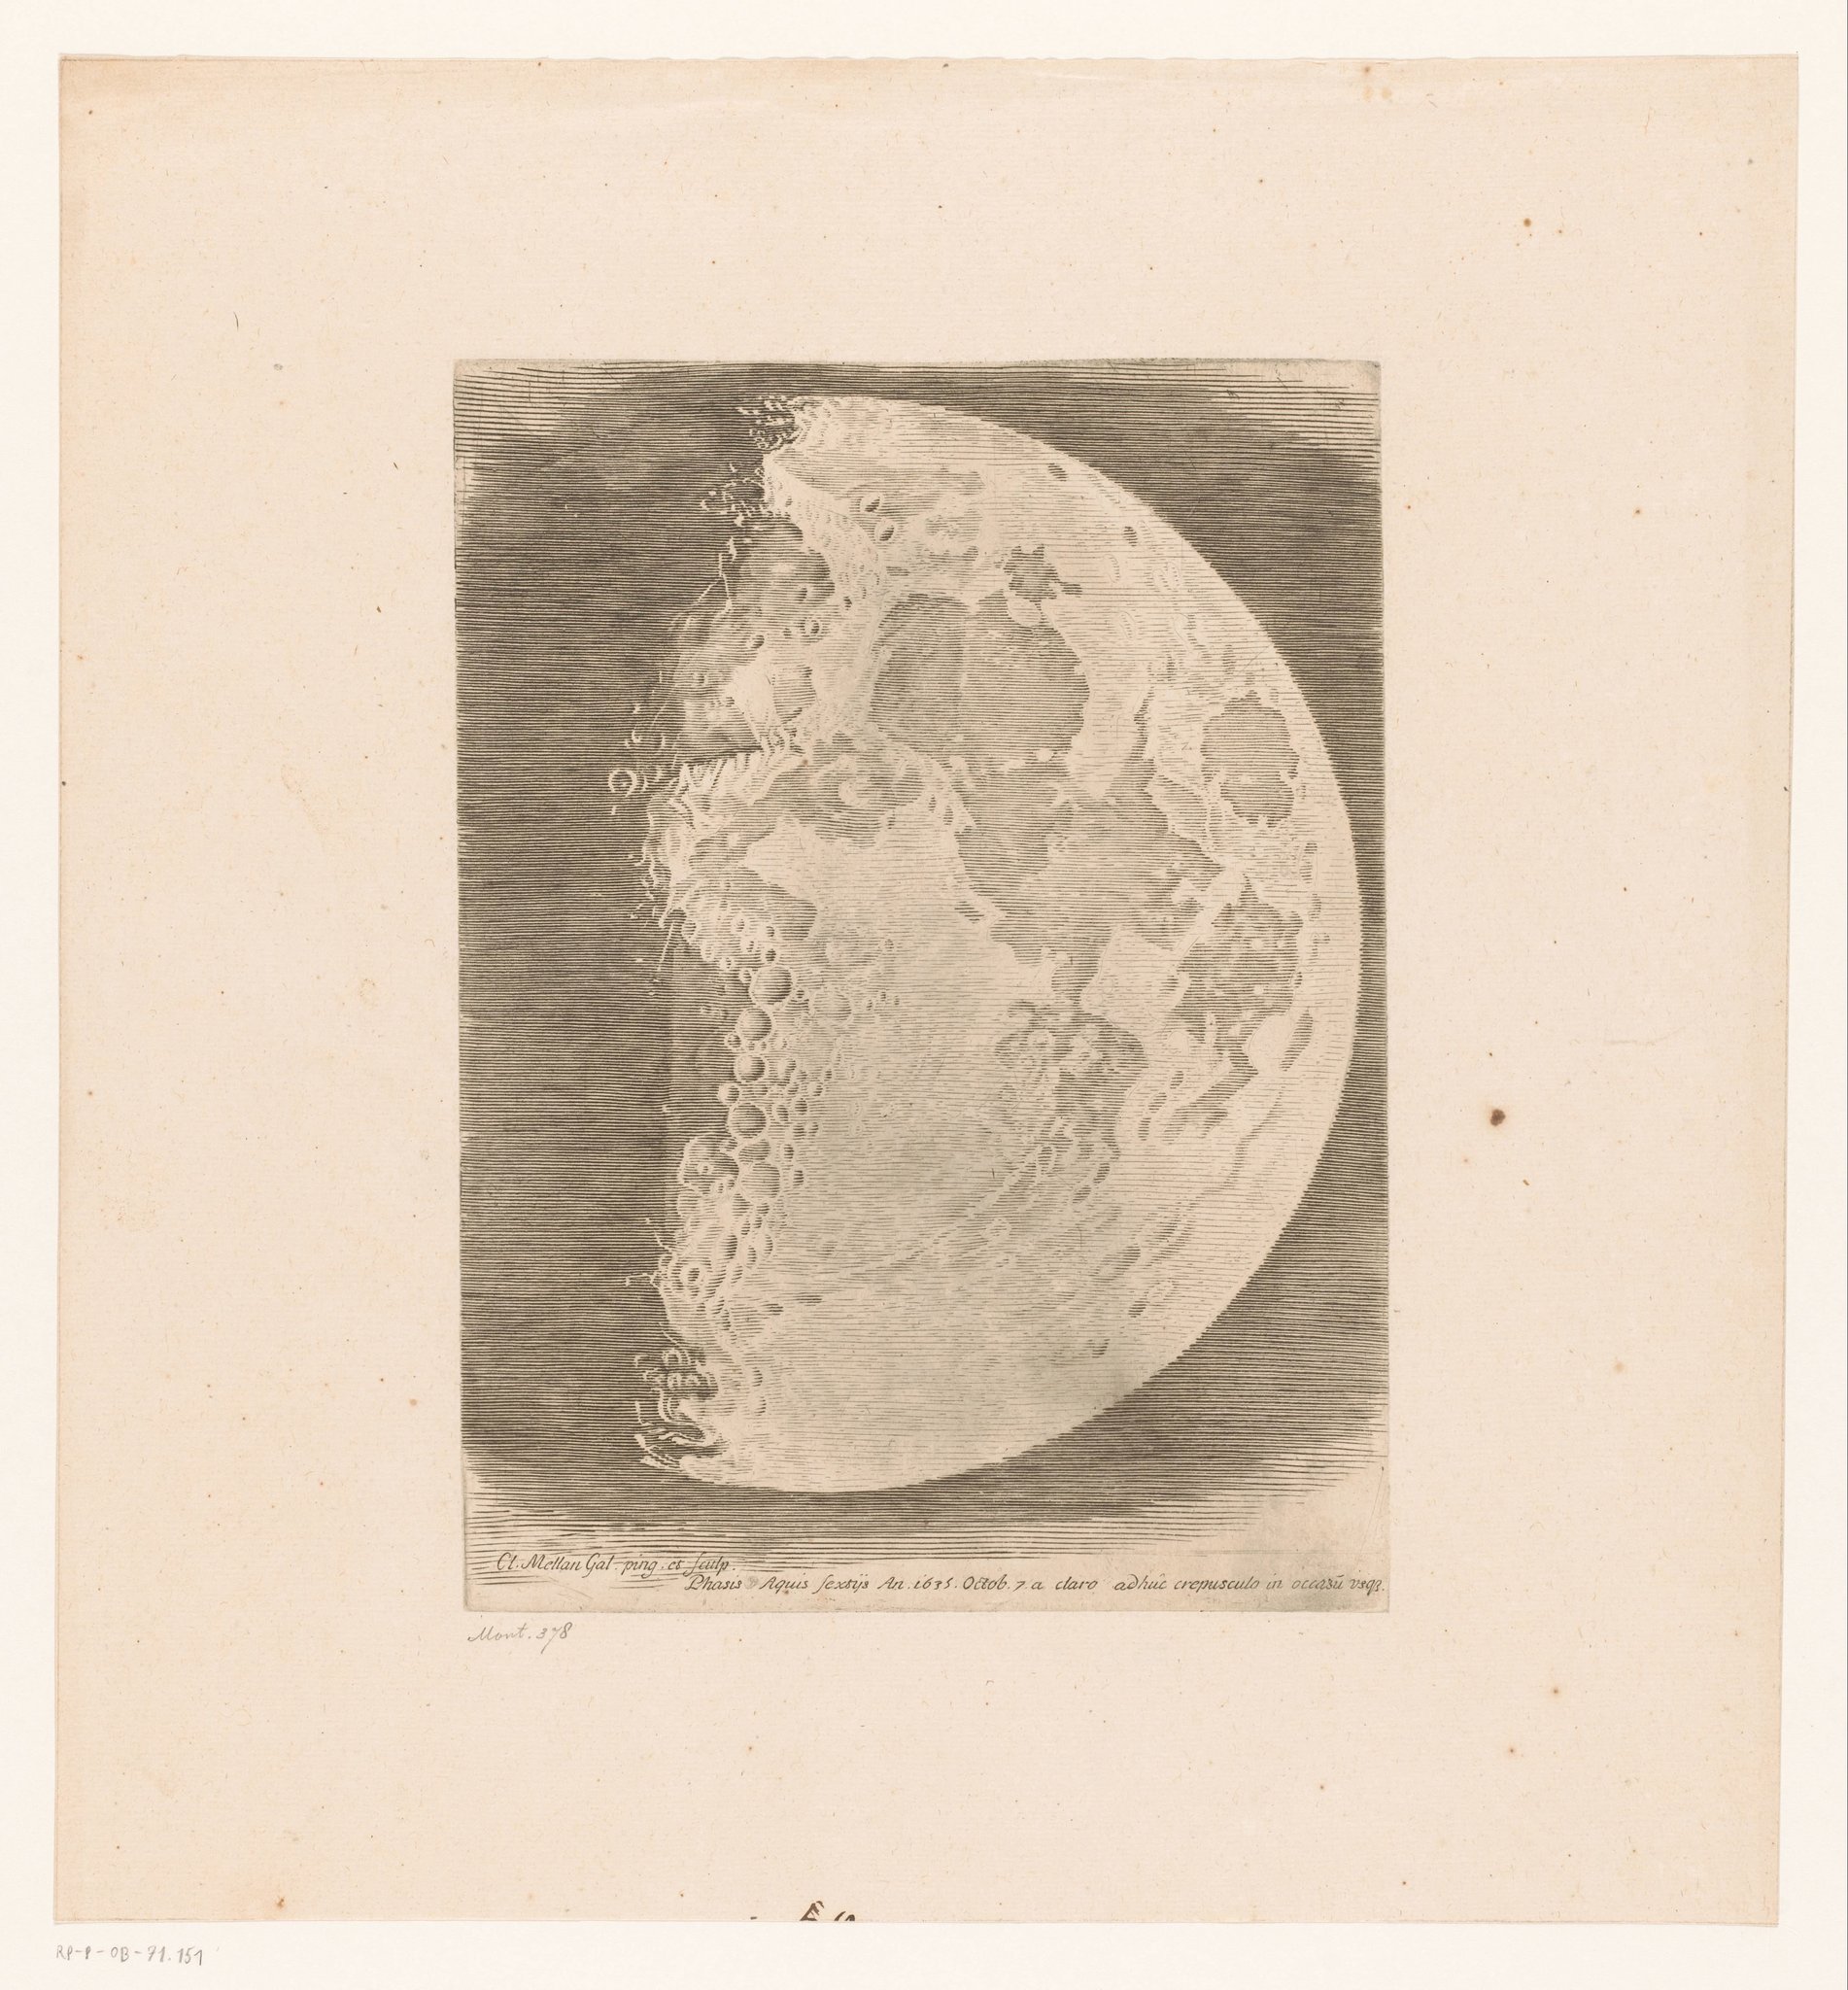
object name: print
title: Eerste kwartier van de maan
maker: claude mellan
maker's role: draughtsman, print maker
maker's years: 1598-1688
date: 1635-1688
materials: paper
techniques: engraving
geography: rome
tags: waxing moon, i.e. facing this way: )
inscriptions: collector's mark: Lugt 240